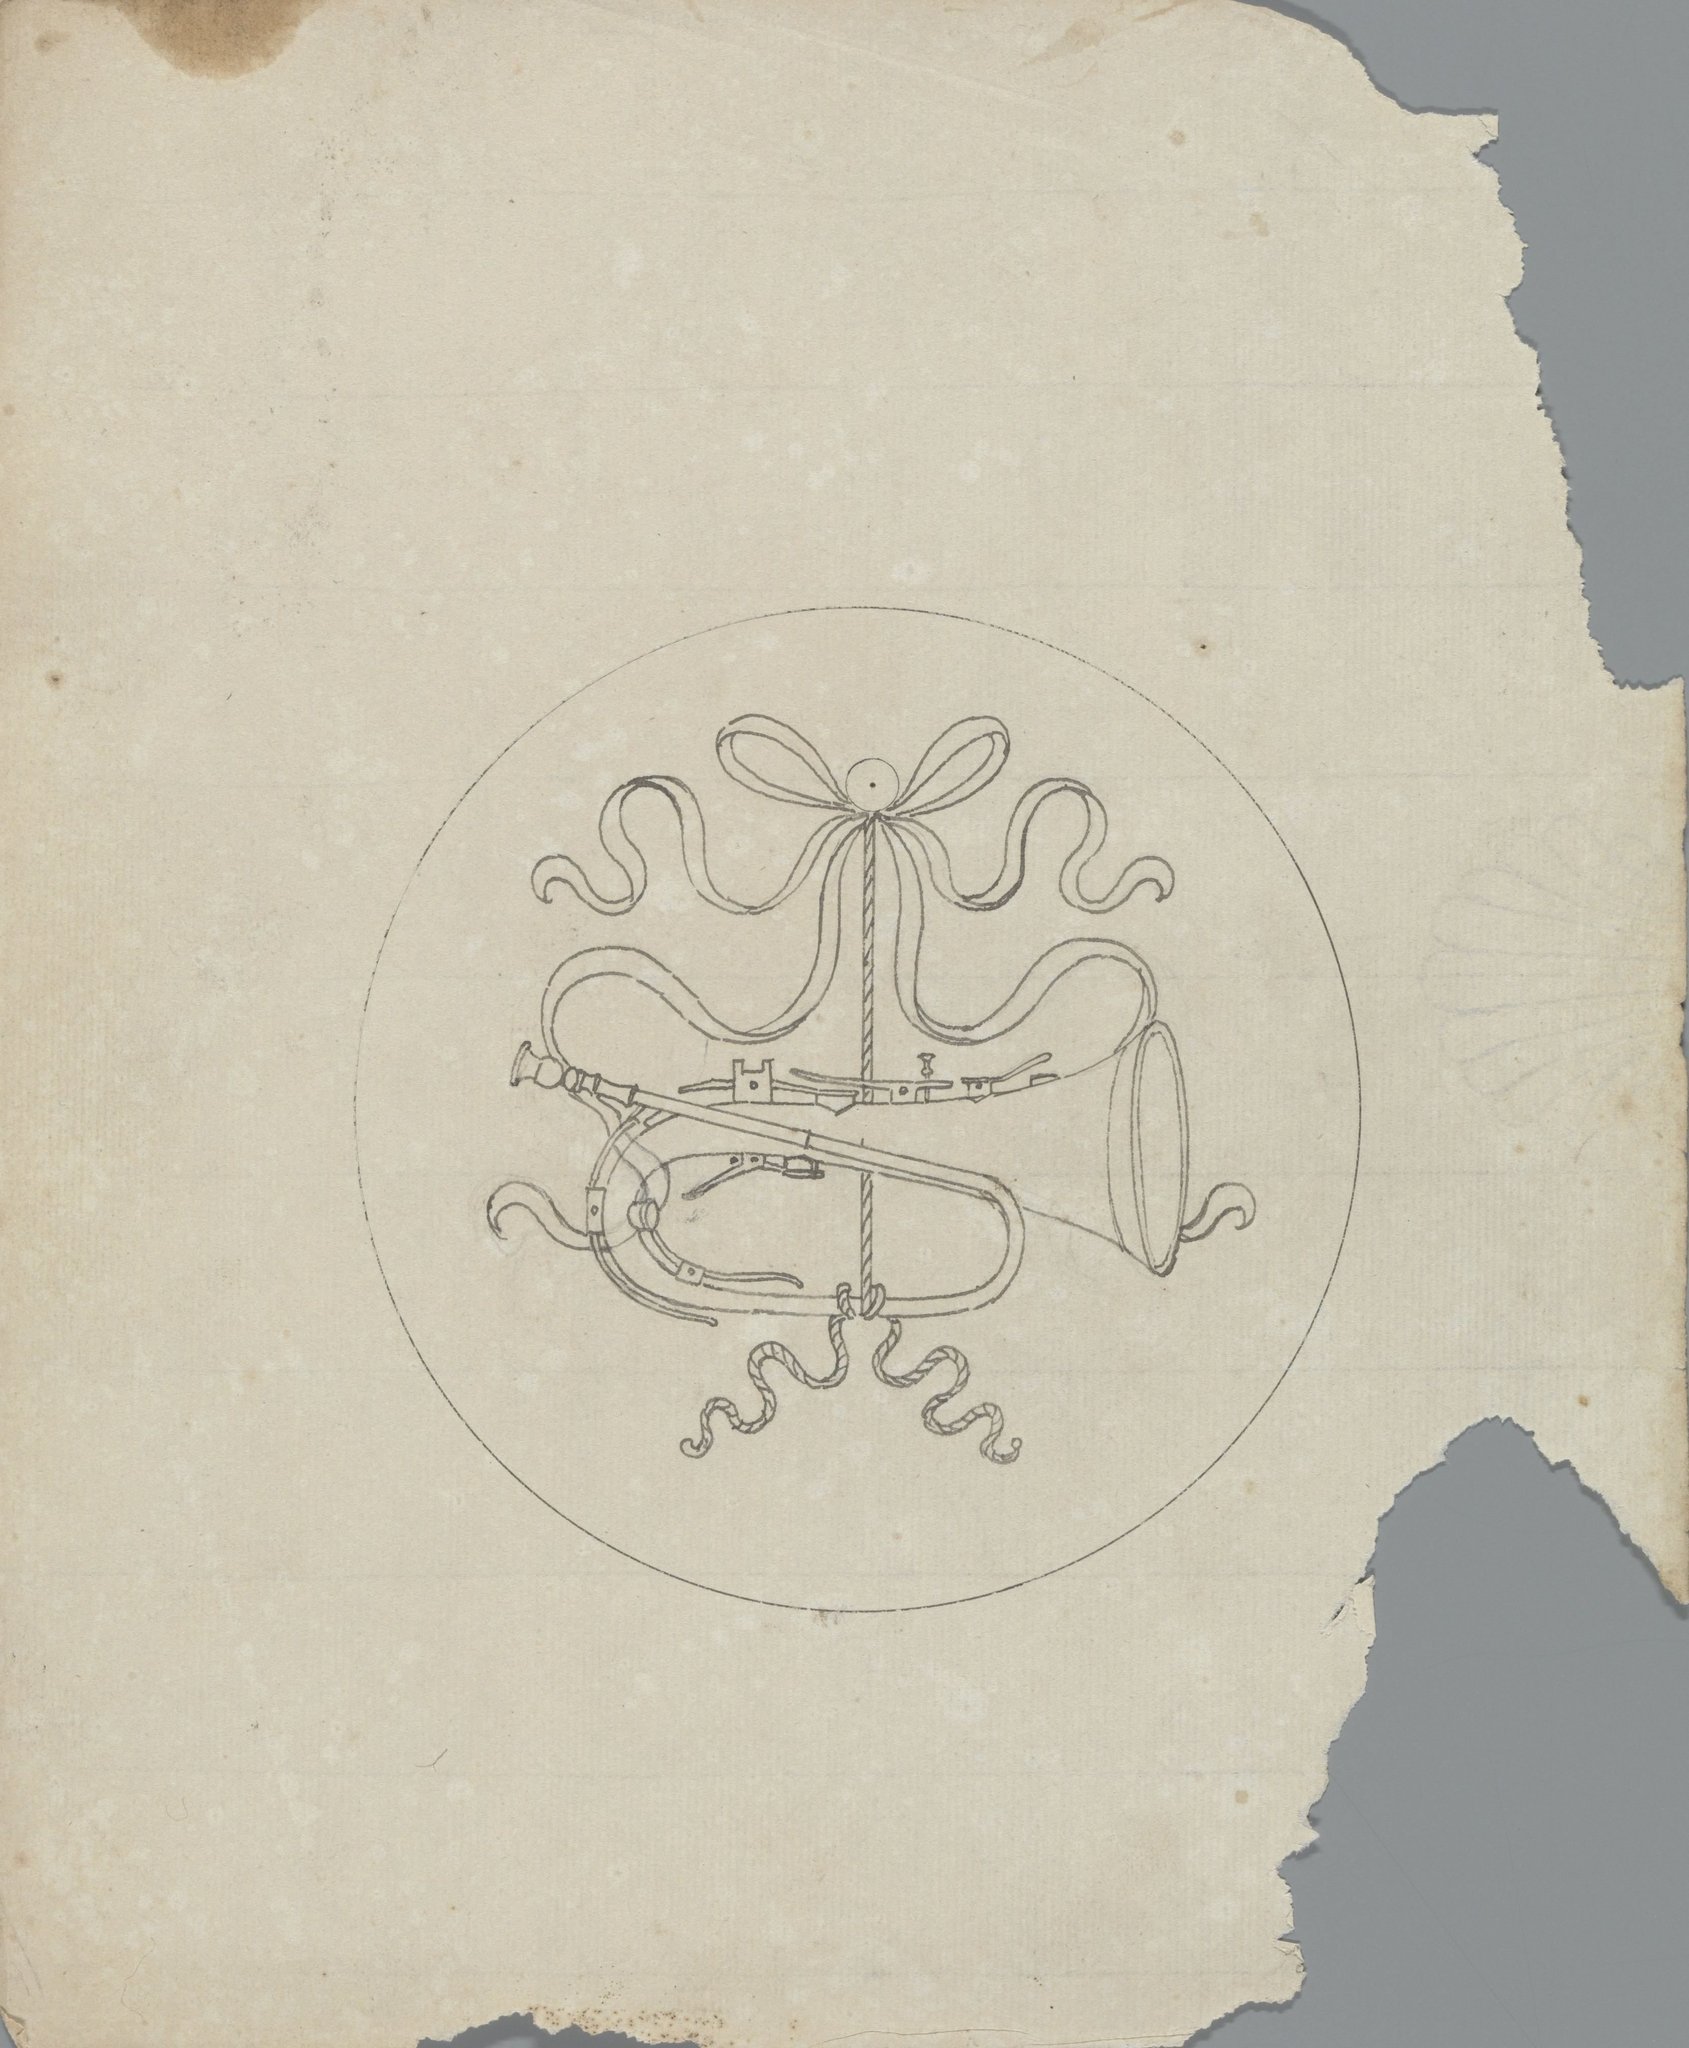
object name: design drawing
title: Ontwerp voor marqueterie van aan linten opgehangen muziekinstrument(en) in rond medaillon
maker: pierre félix van doren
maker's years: 1797-1856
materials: graphite, ink, paper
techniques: pen in black ink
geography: brussels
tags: trophy, i.e.: decorative arrangement of symbolic or typical objects ~ ornament, horn, trumpet, cornet, trombone, tuba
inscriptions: watermark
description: Een van 103 ontwerpen voor marqueterie van aan linten opgehangen muziekinstrumenten in ronde medaillons, bestemd voor de set stoelen gemaakt door Van Doren voor de grote zaal van het Paleis van de Prins van Oranje in Brussel in 1828.